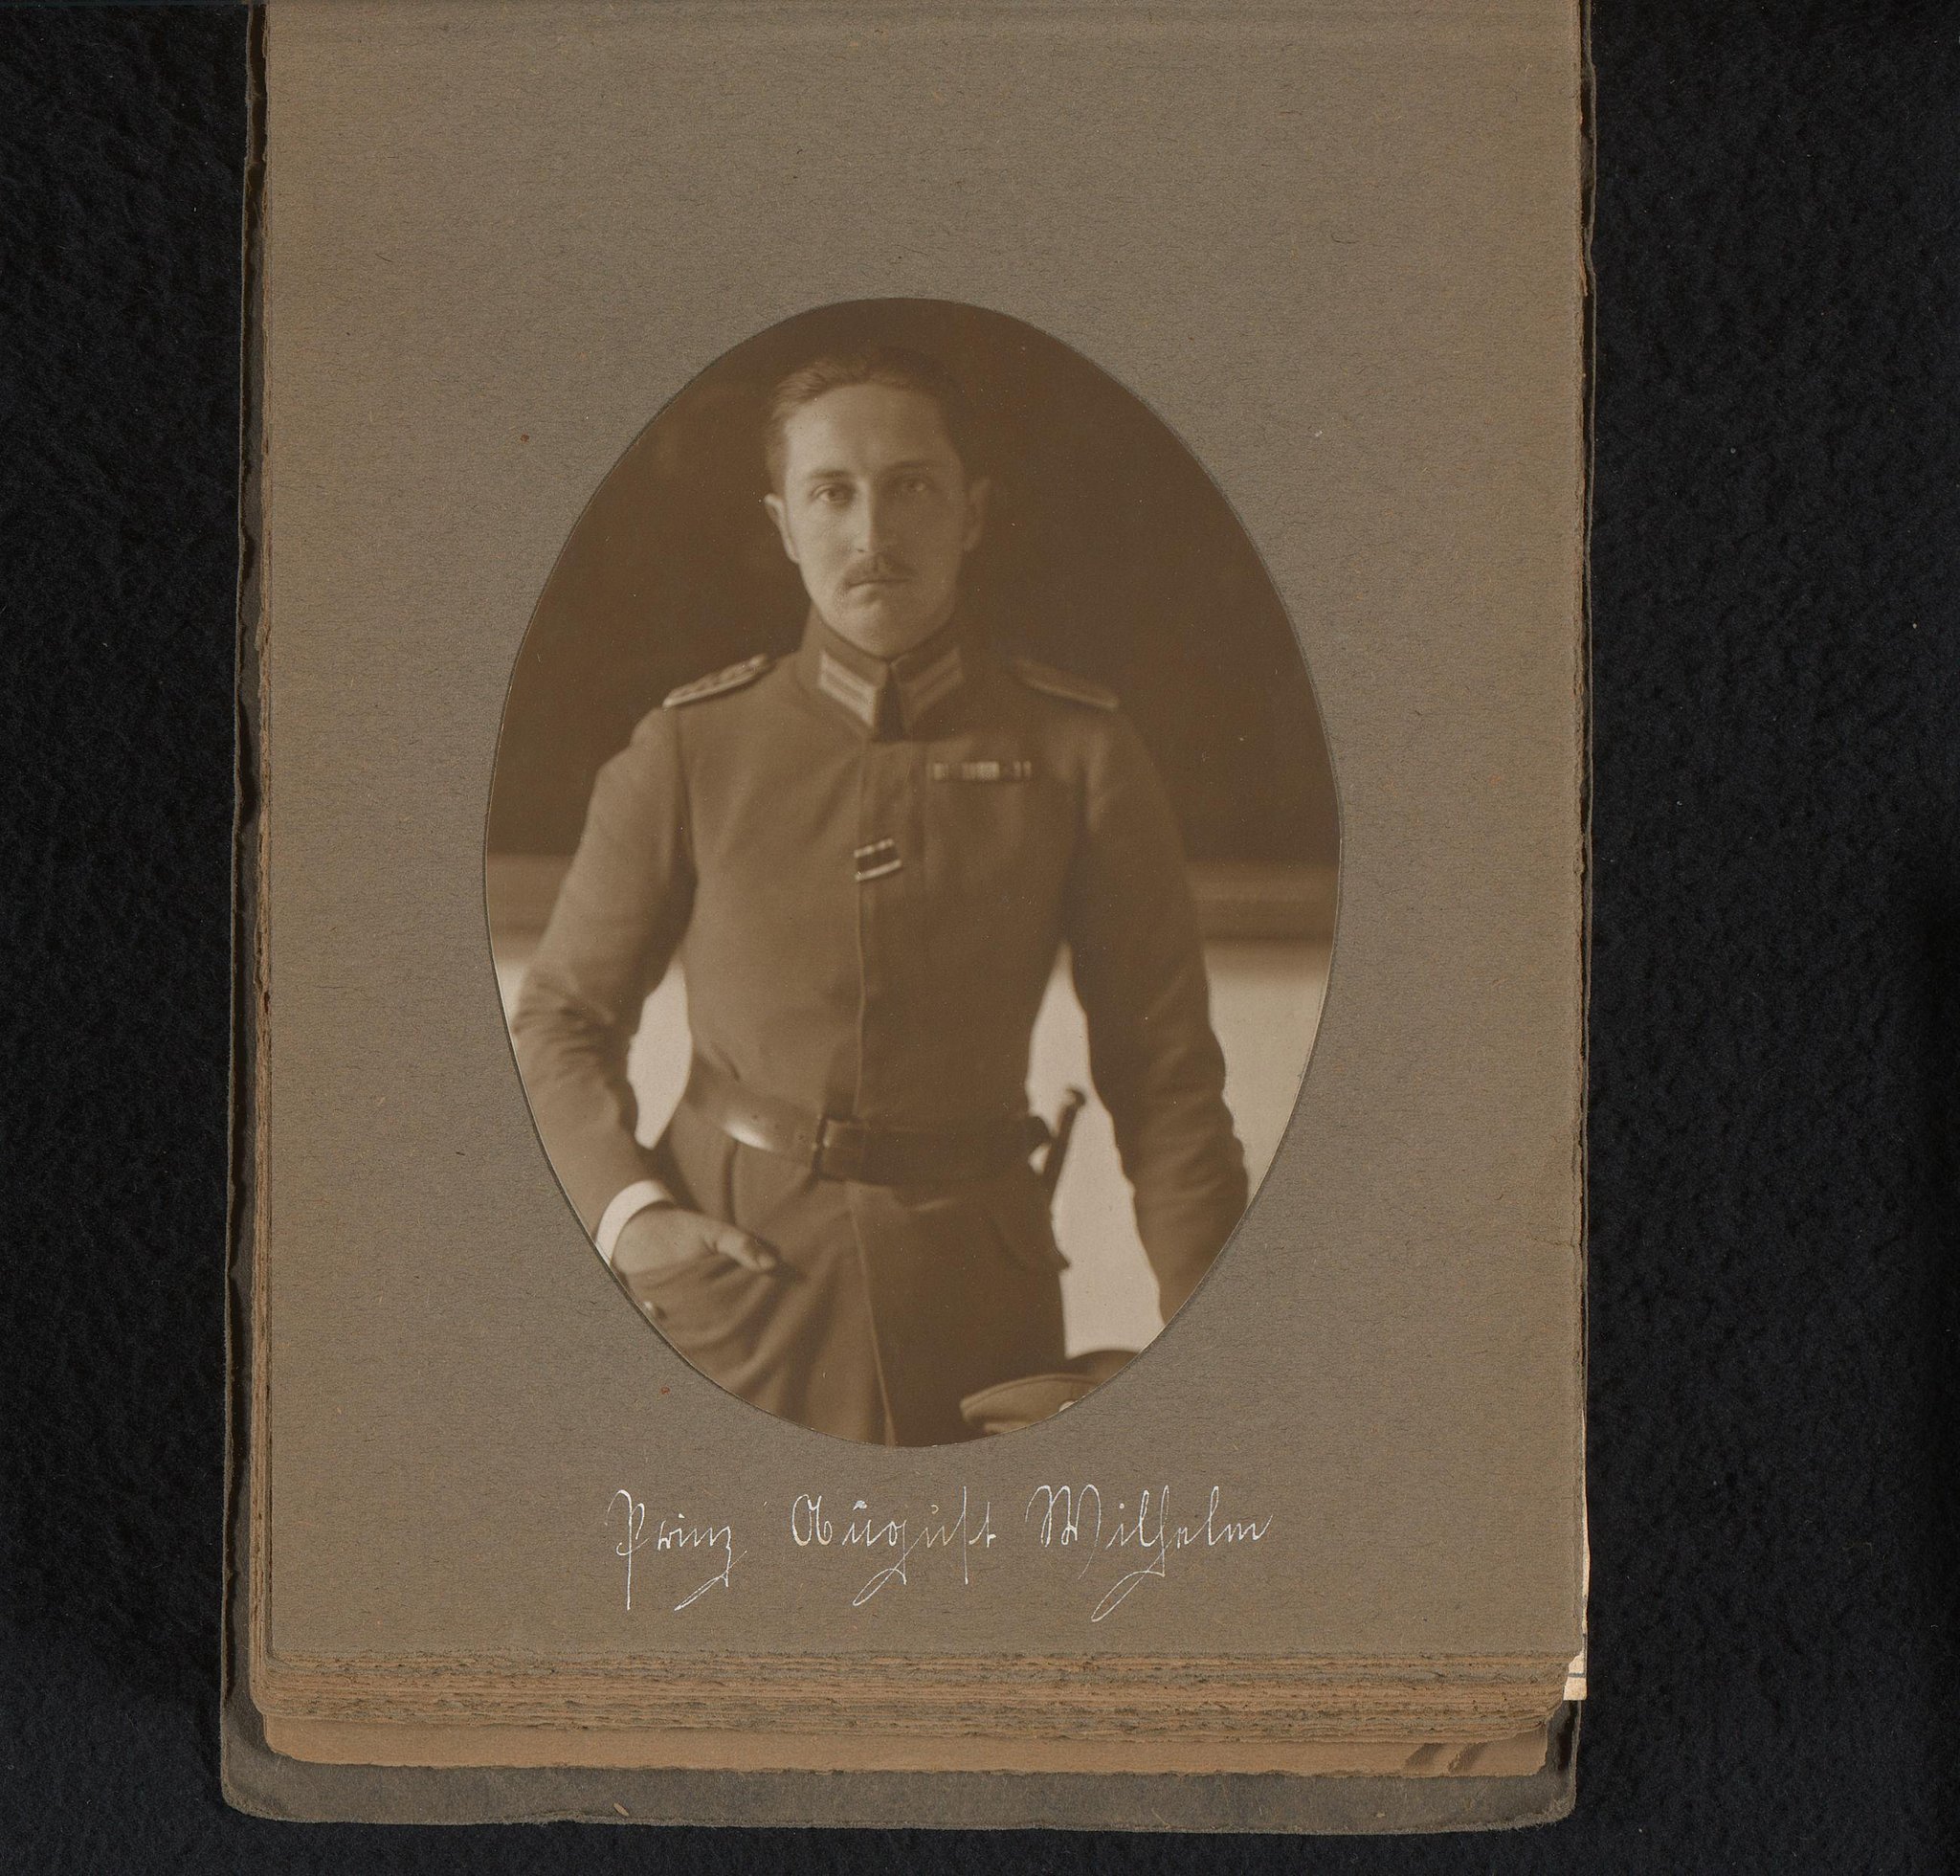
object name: photograph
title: Portret van August Wilhelm van Pruisen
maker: Anonymous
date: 1910-1917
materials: paper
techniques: gelatin silver print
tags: prince, historical persons